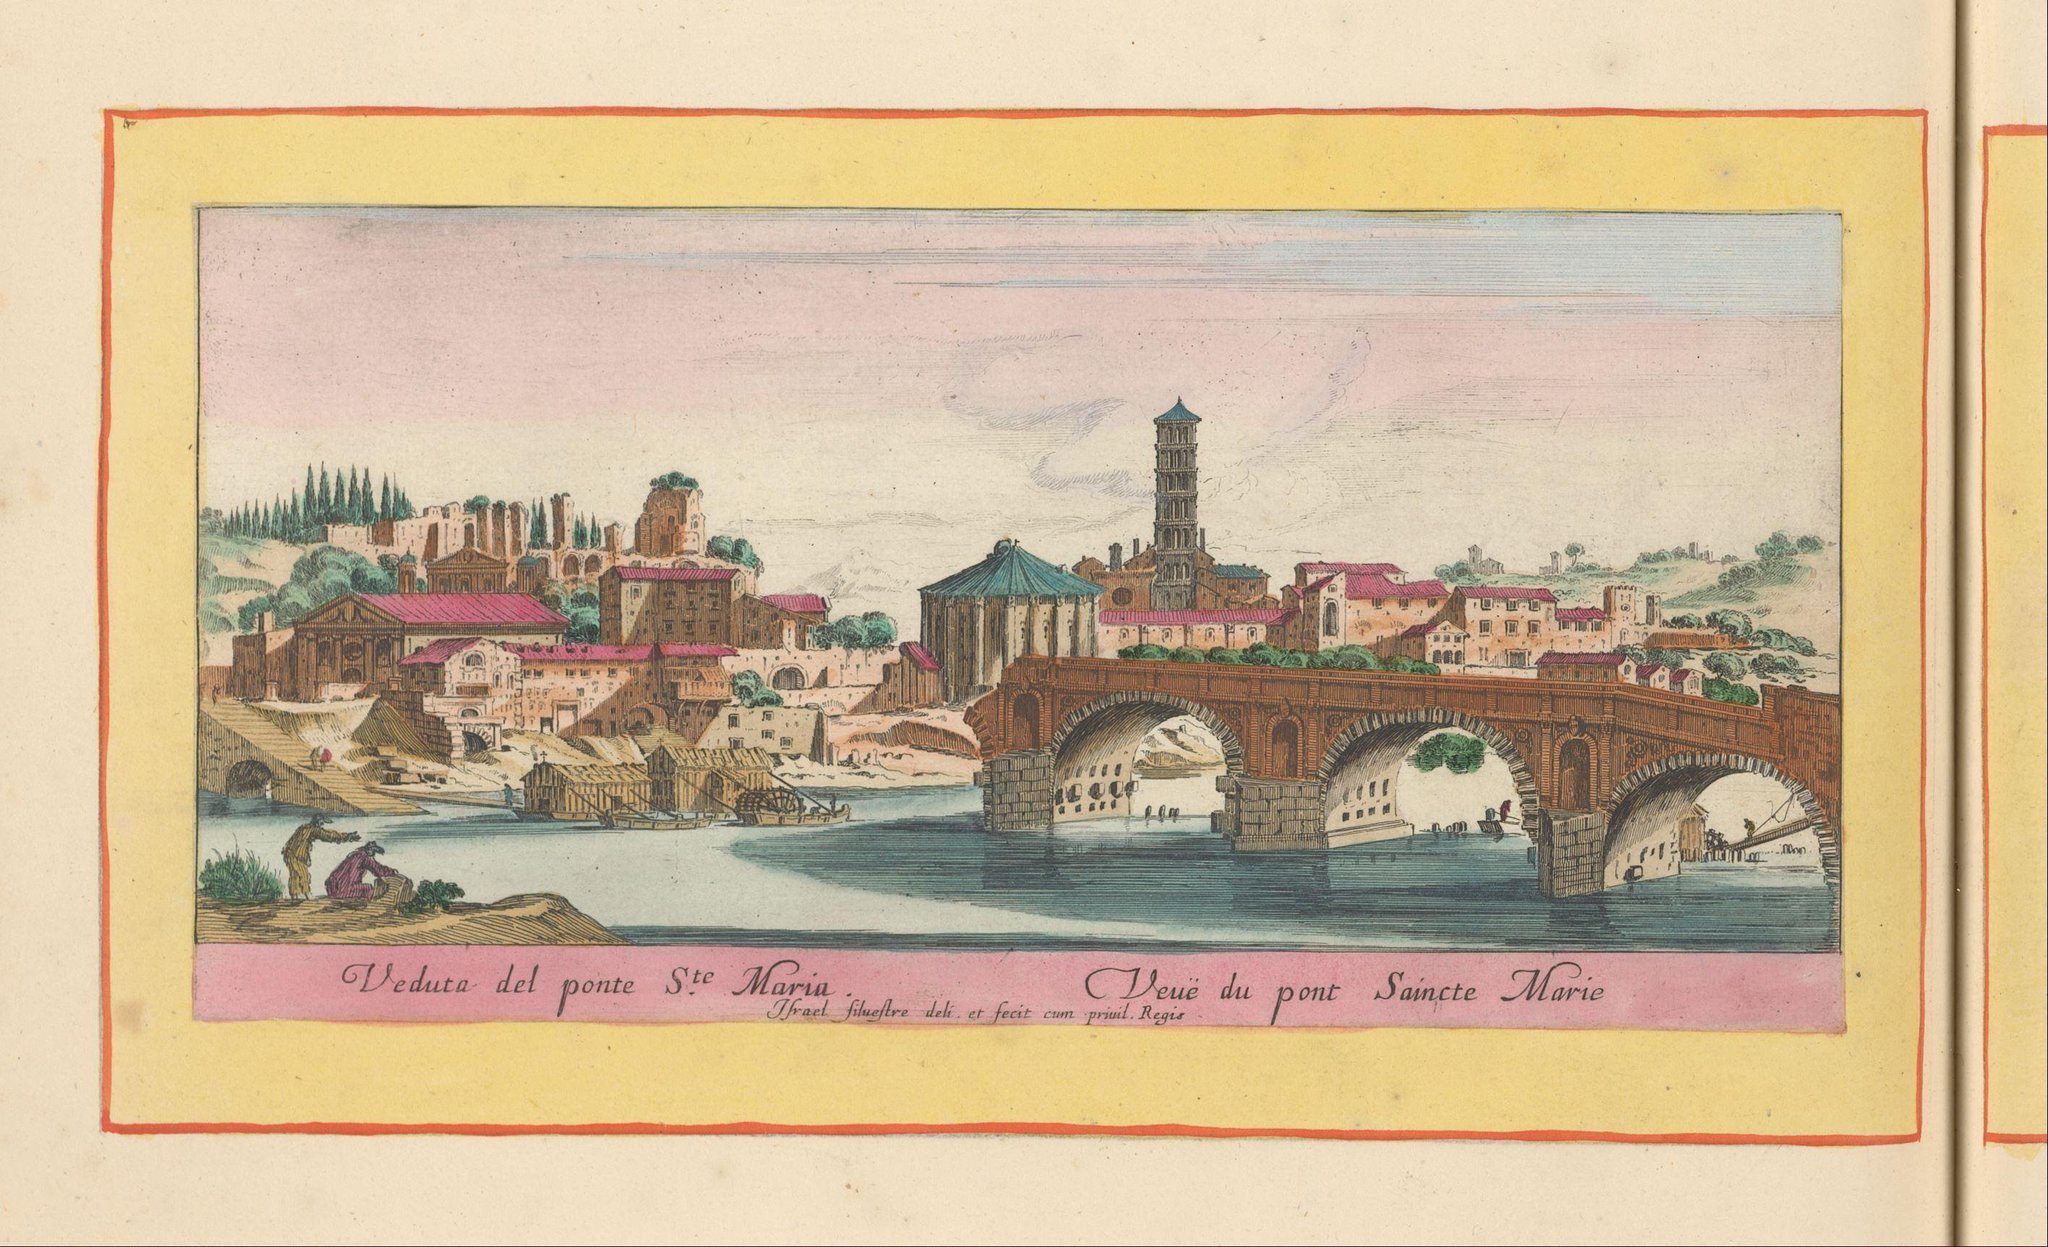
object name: print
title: Ponte Rotto te Rome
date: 1631-1691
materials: paper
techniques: colour, etching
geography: paris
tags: landscape with ruins, bridge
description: Gezicht op een deel van de resten van de Ponte Rotto die over de rivier de Tiber gaat te Rome. Titel in het Italiaans en het Frans in de ondermarge. Prent maakt deel uit van een album.